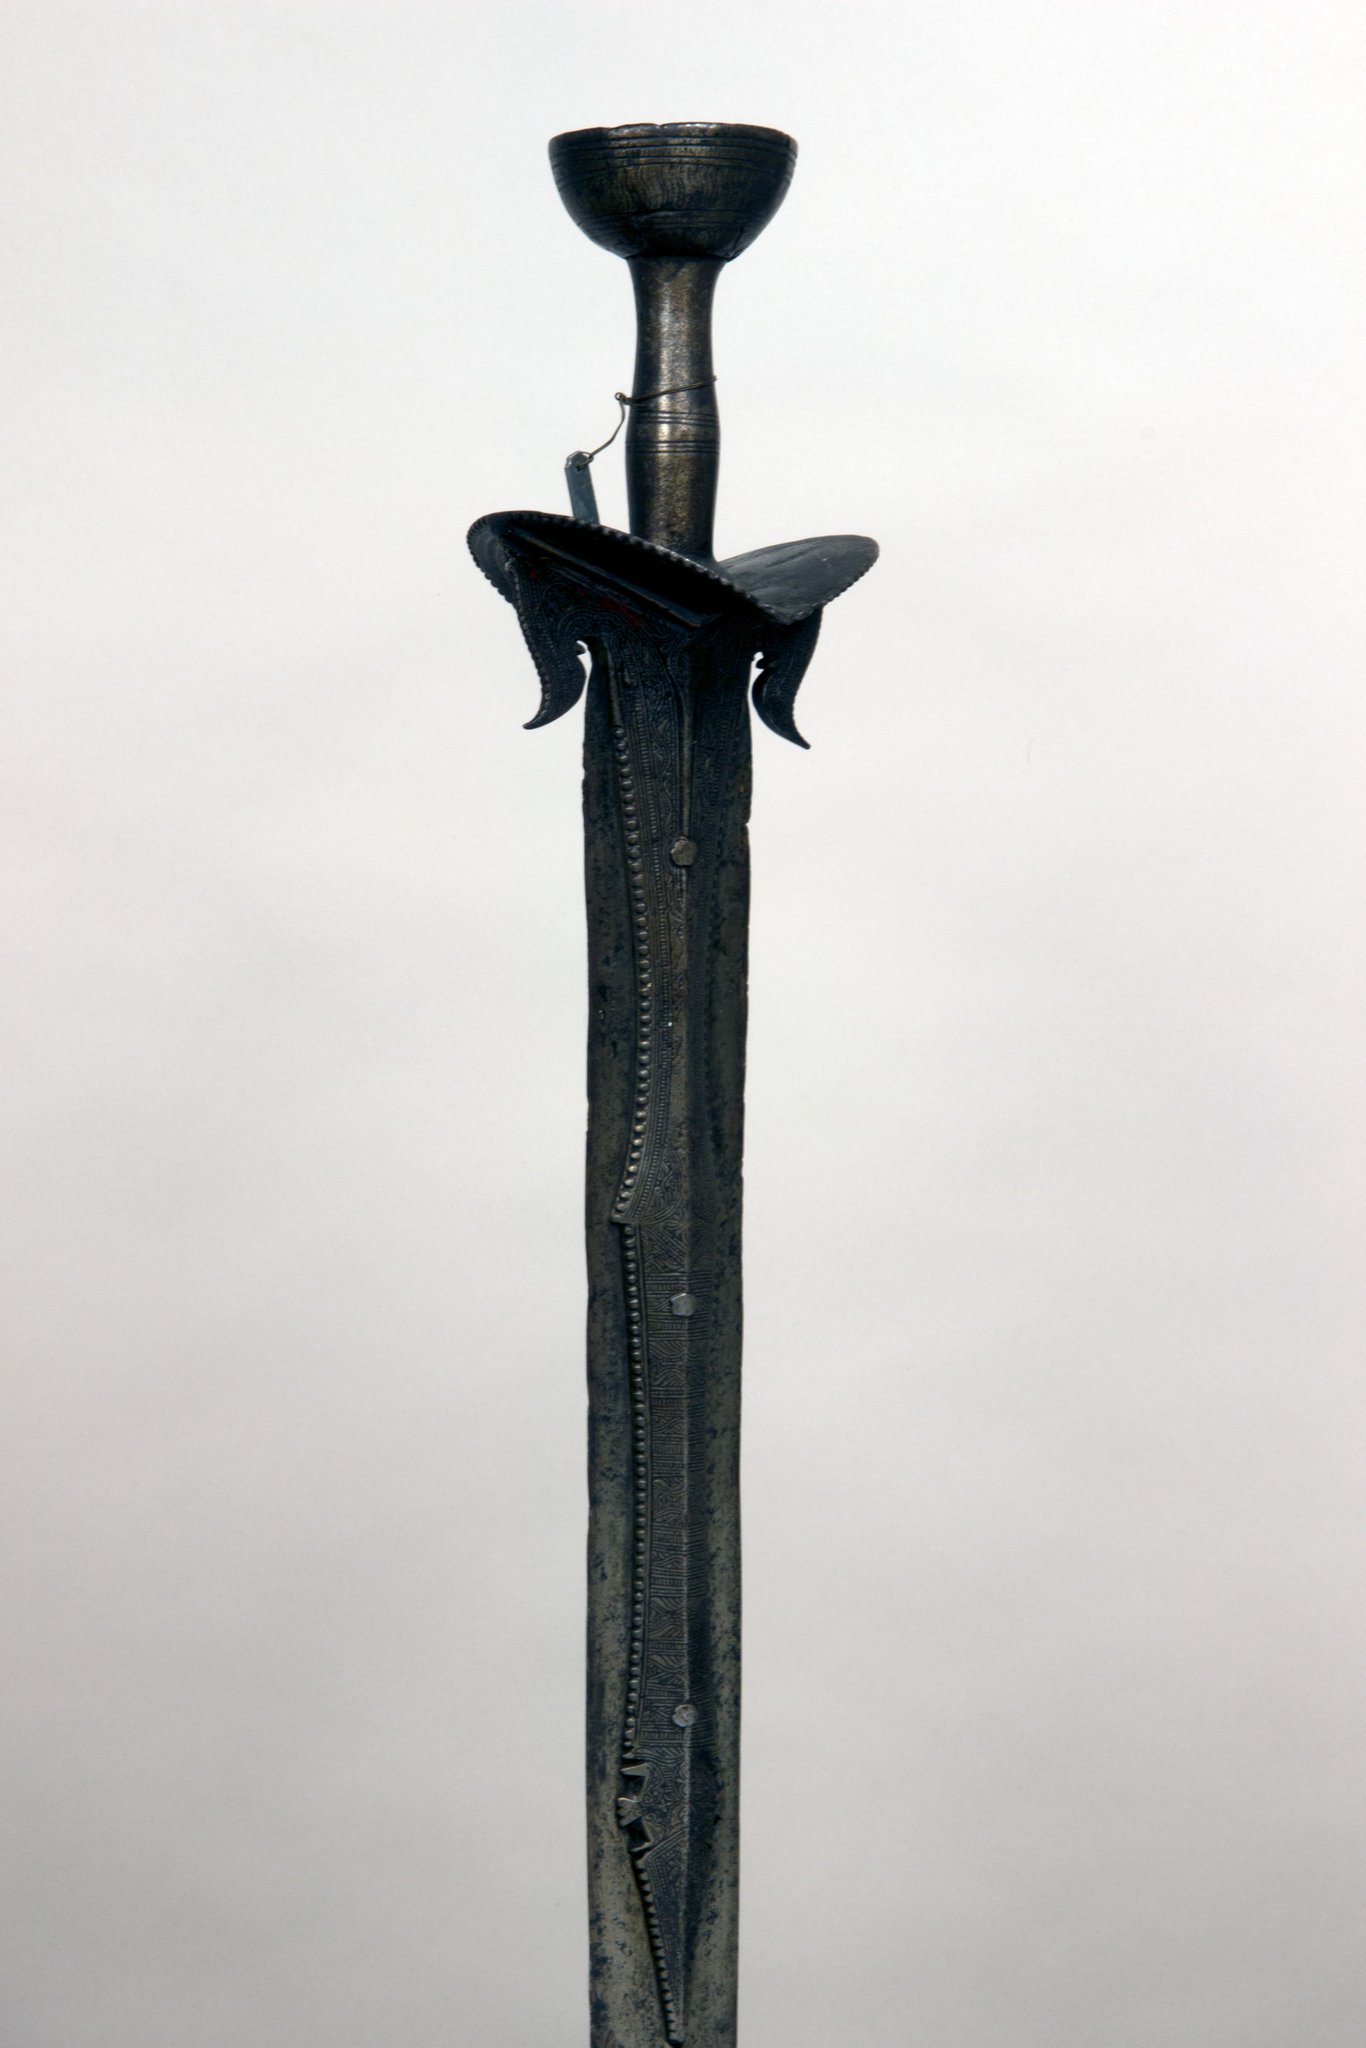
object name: sword pattisa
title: Sword (Pattisa)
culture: indian, south indian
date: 1601-1800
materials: steel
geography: south india